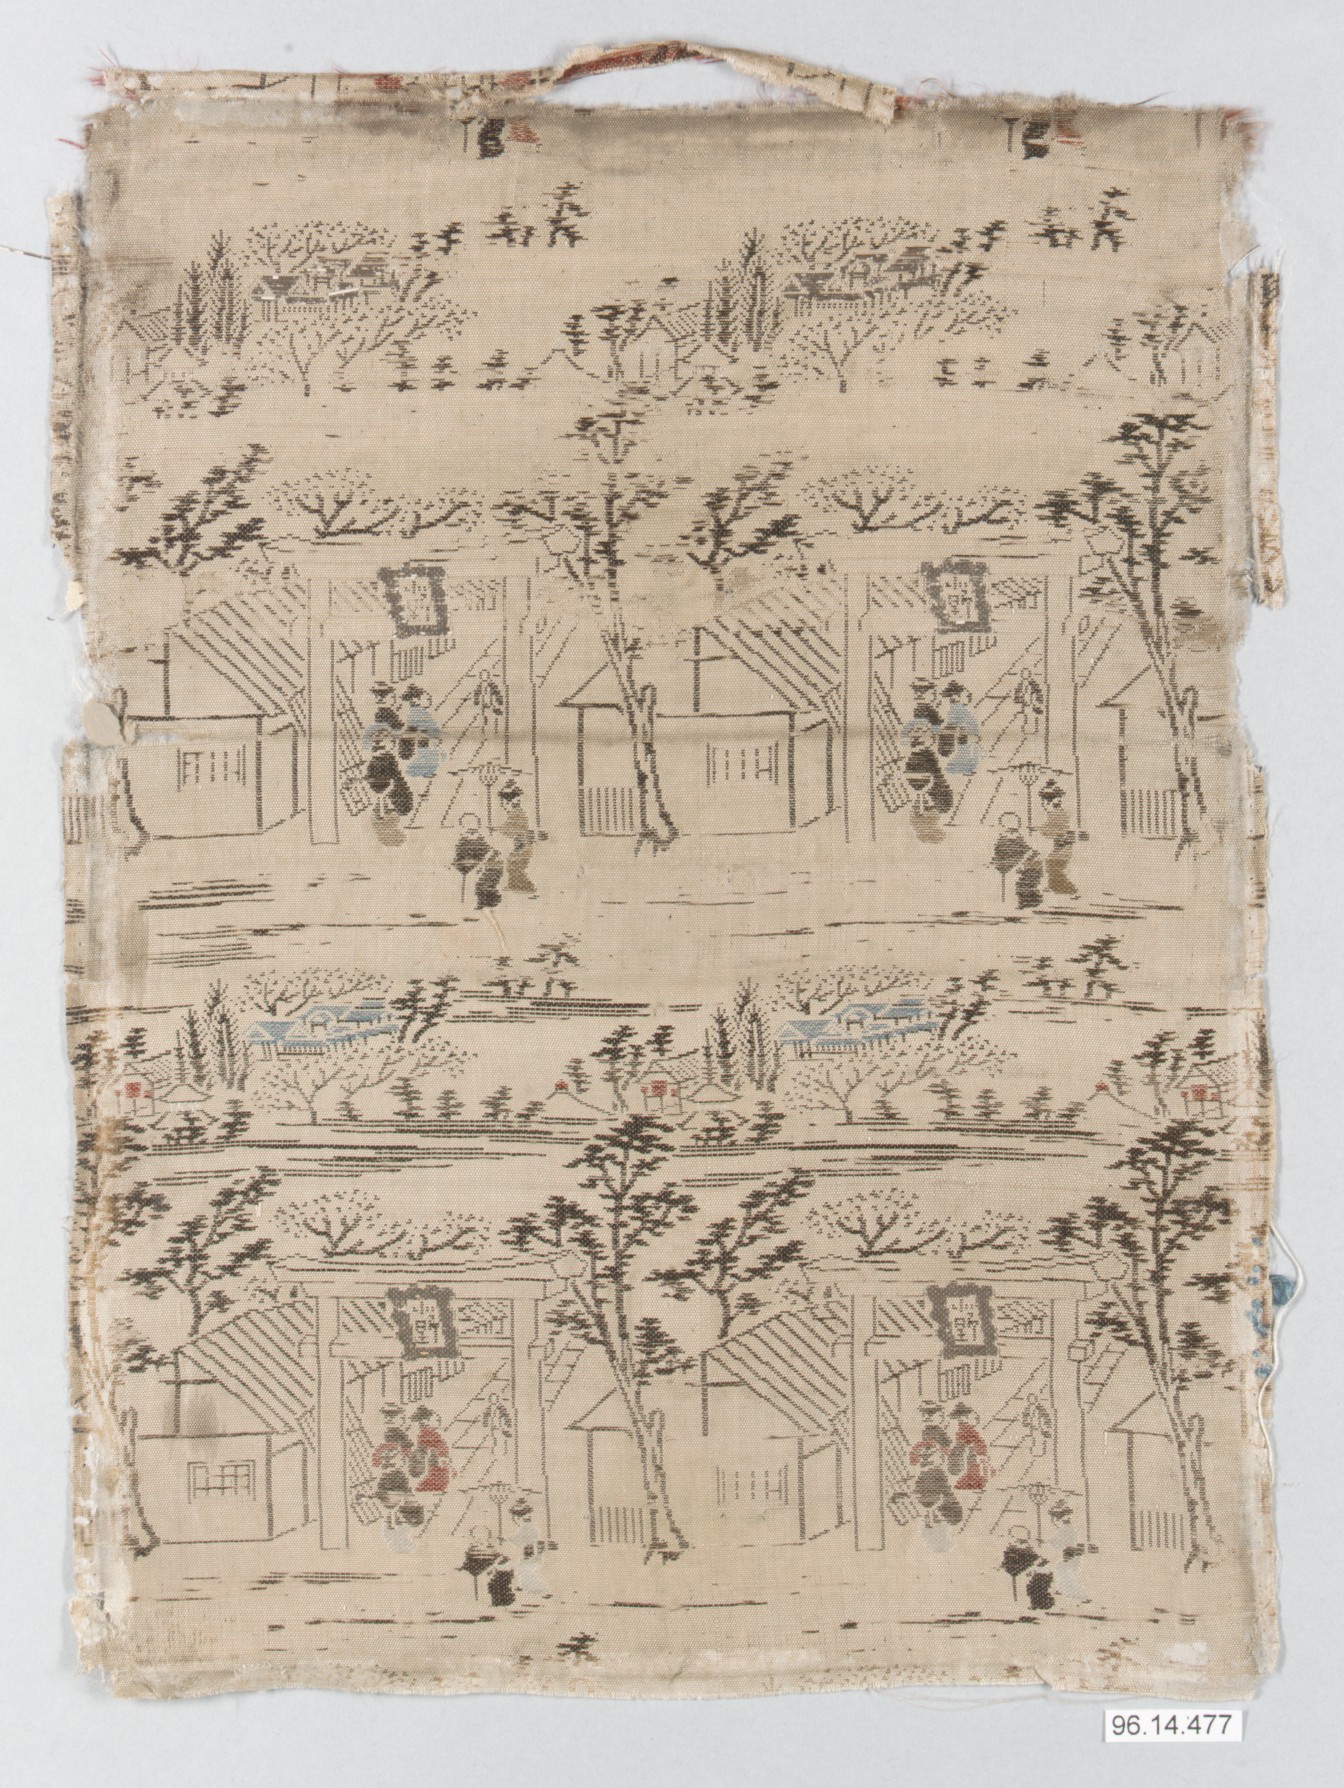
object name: piece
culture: japanese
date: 1801-1833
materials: silk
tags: houses,trees